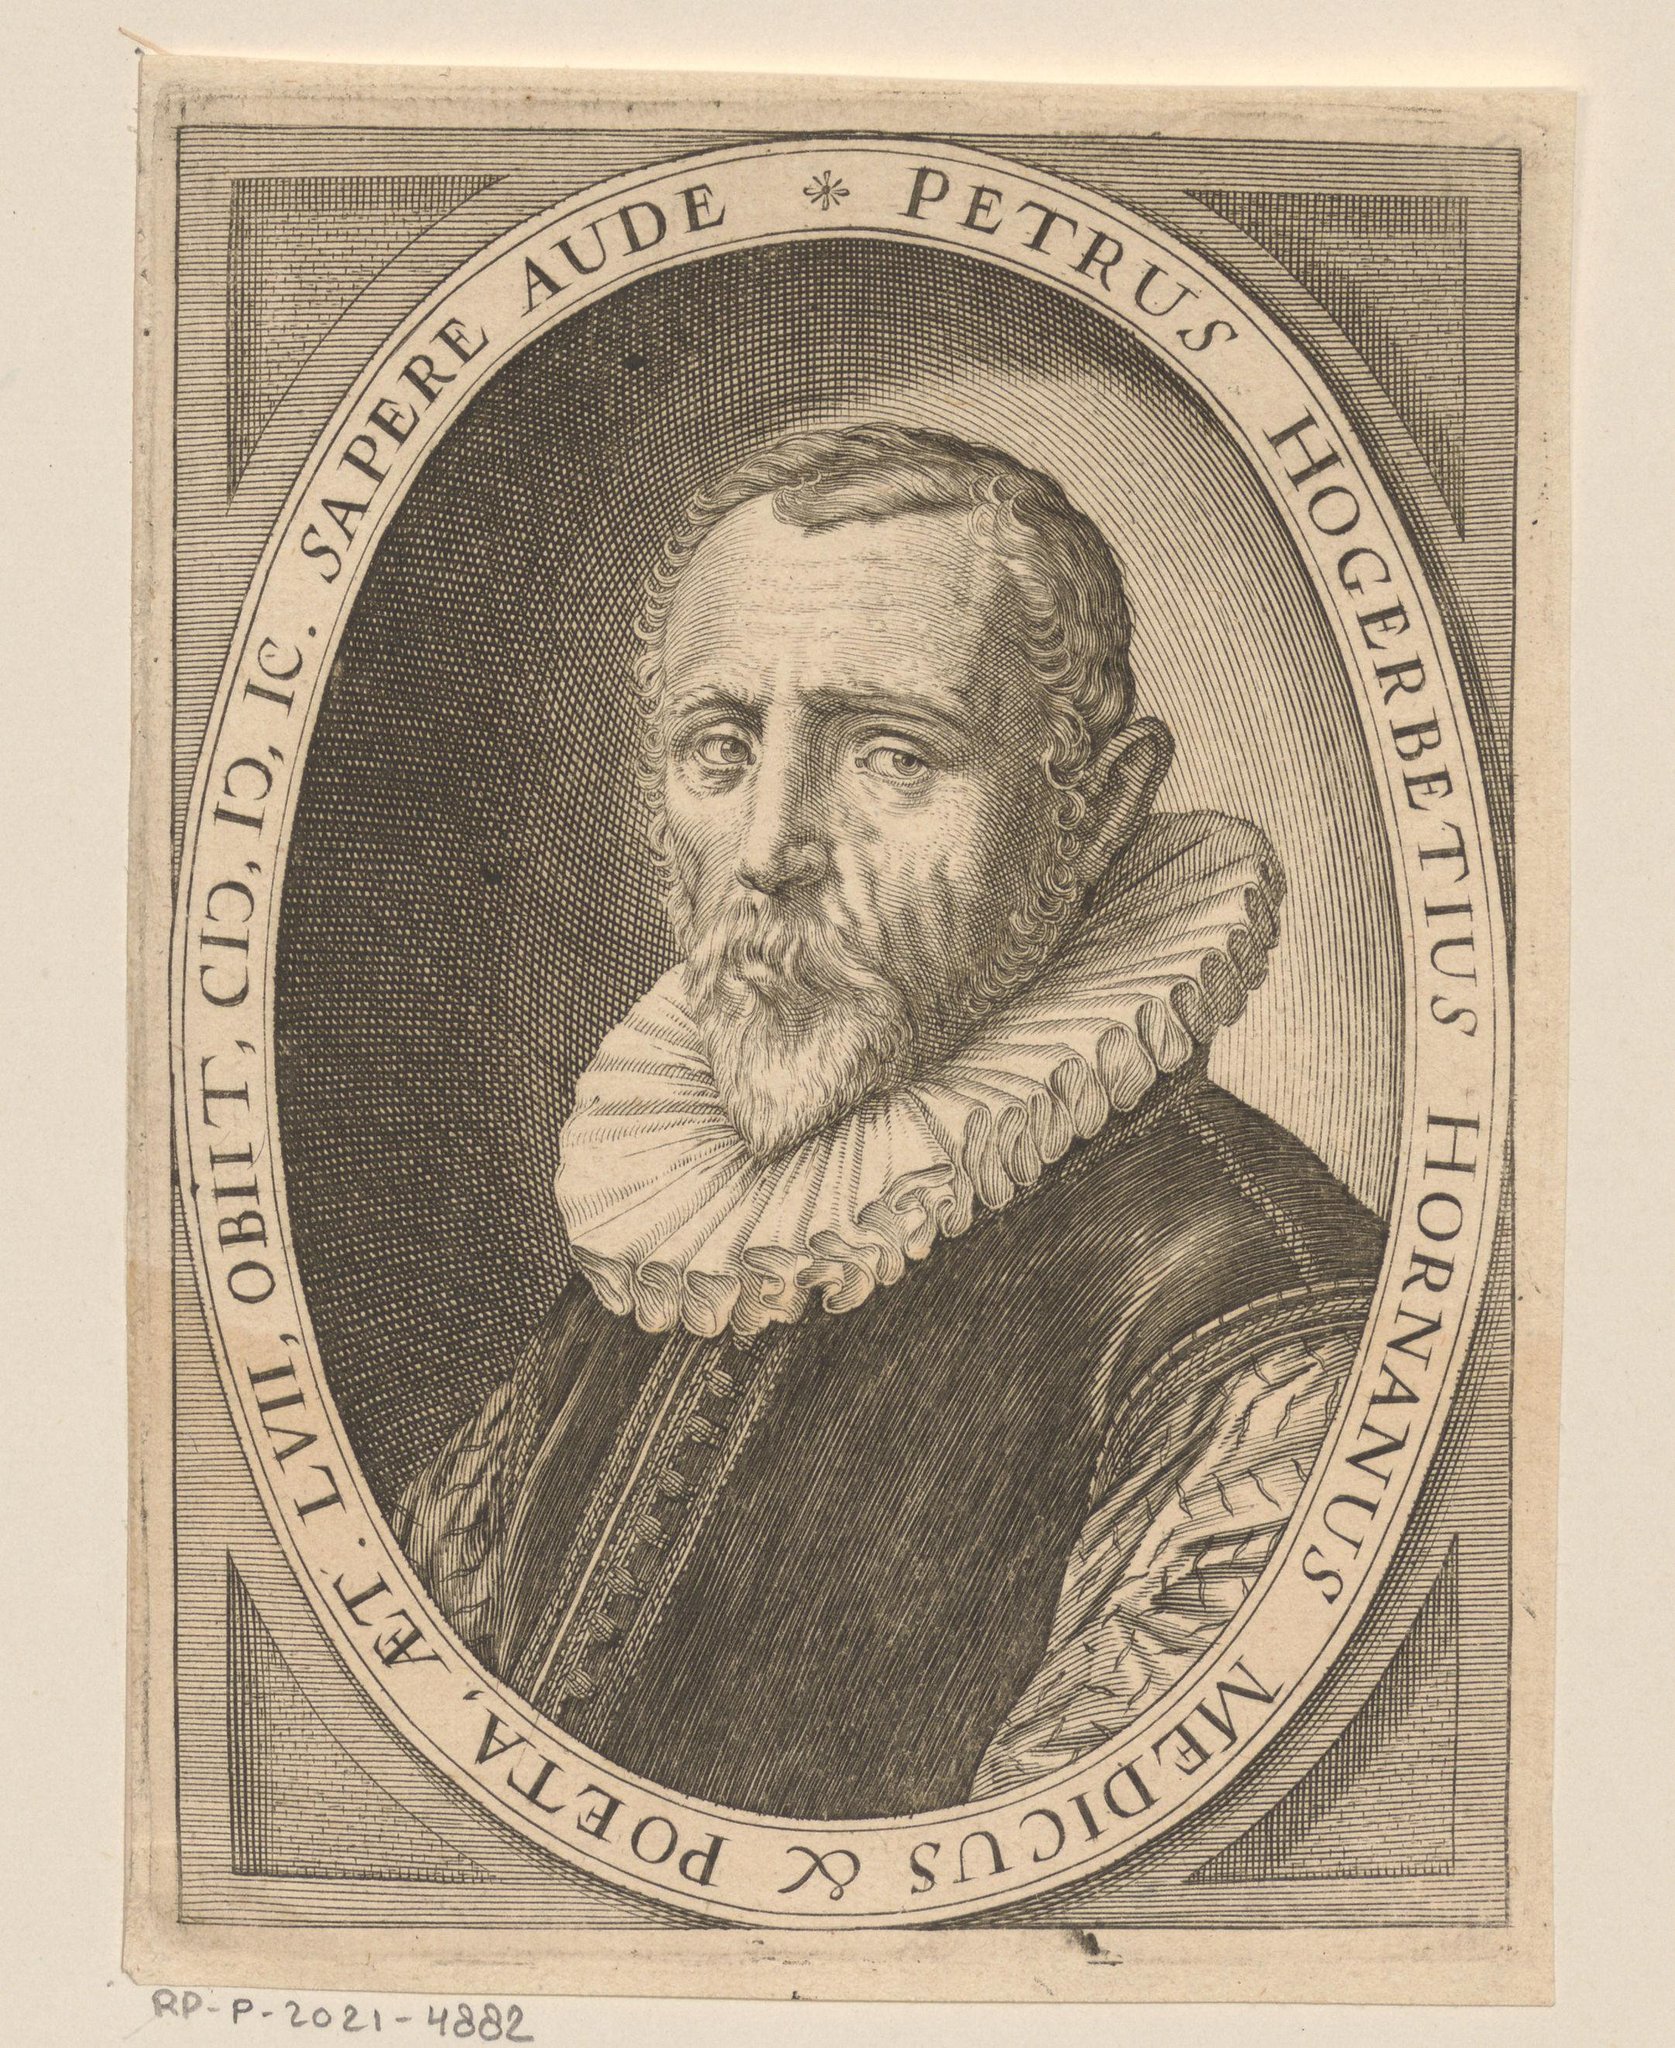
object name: print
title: Portret van Petrus Hogerbeets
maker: Anonymous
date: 1600-1699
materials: paper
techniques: engraving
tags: hoorn (north holland), petrus hogerbeets, historical persons, physician, doctor